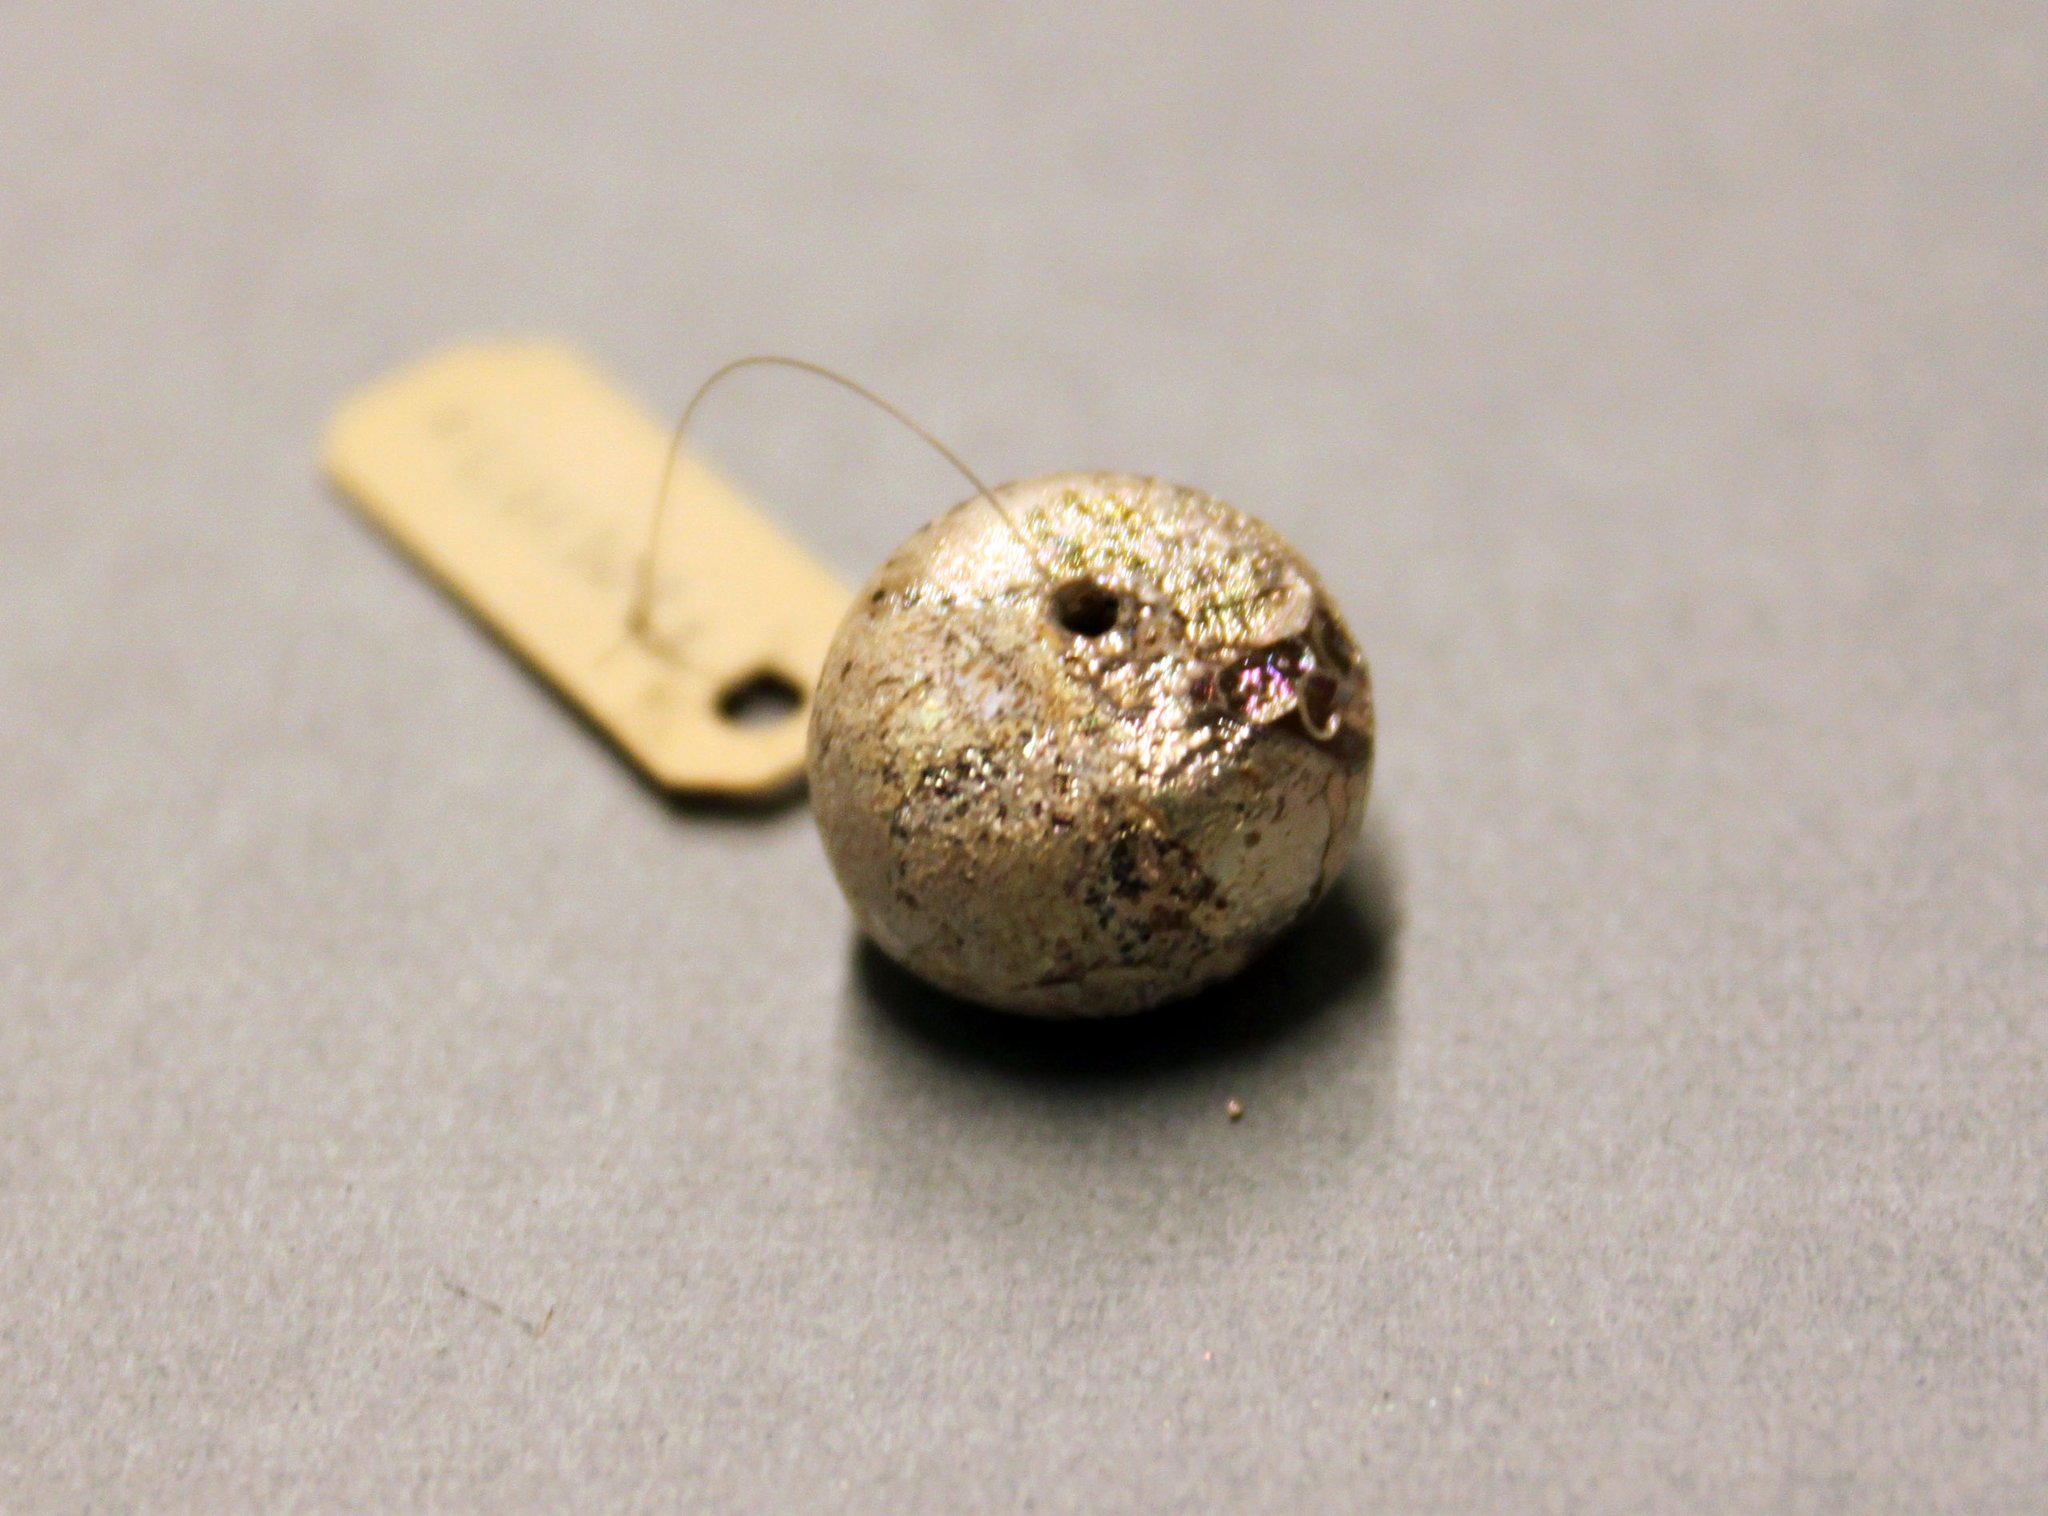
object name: bead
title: Beads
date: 701-1300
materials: glass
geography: iran